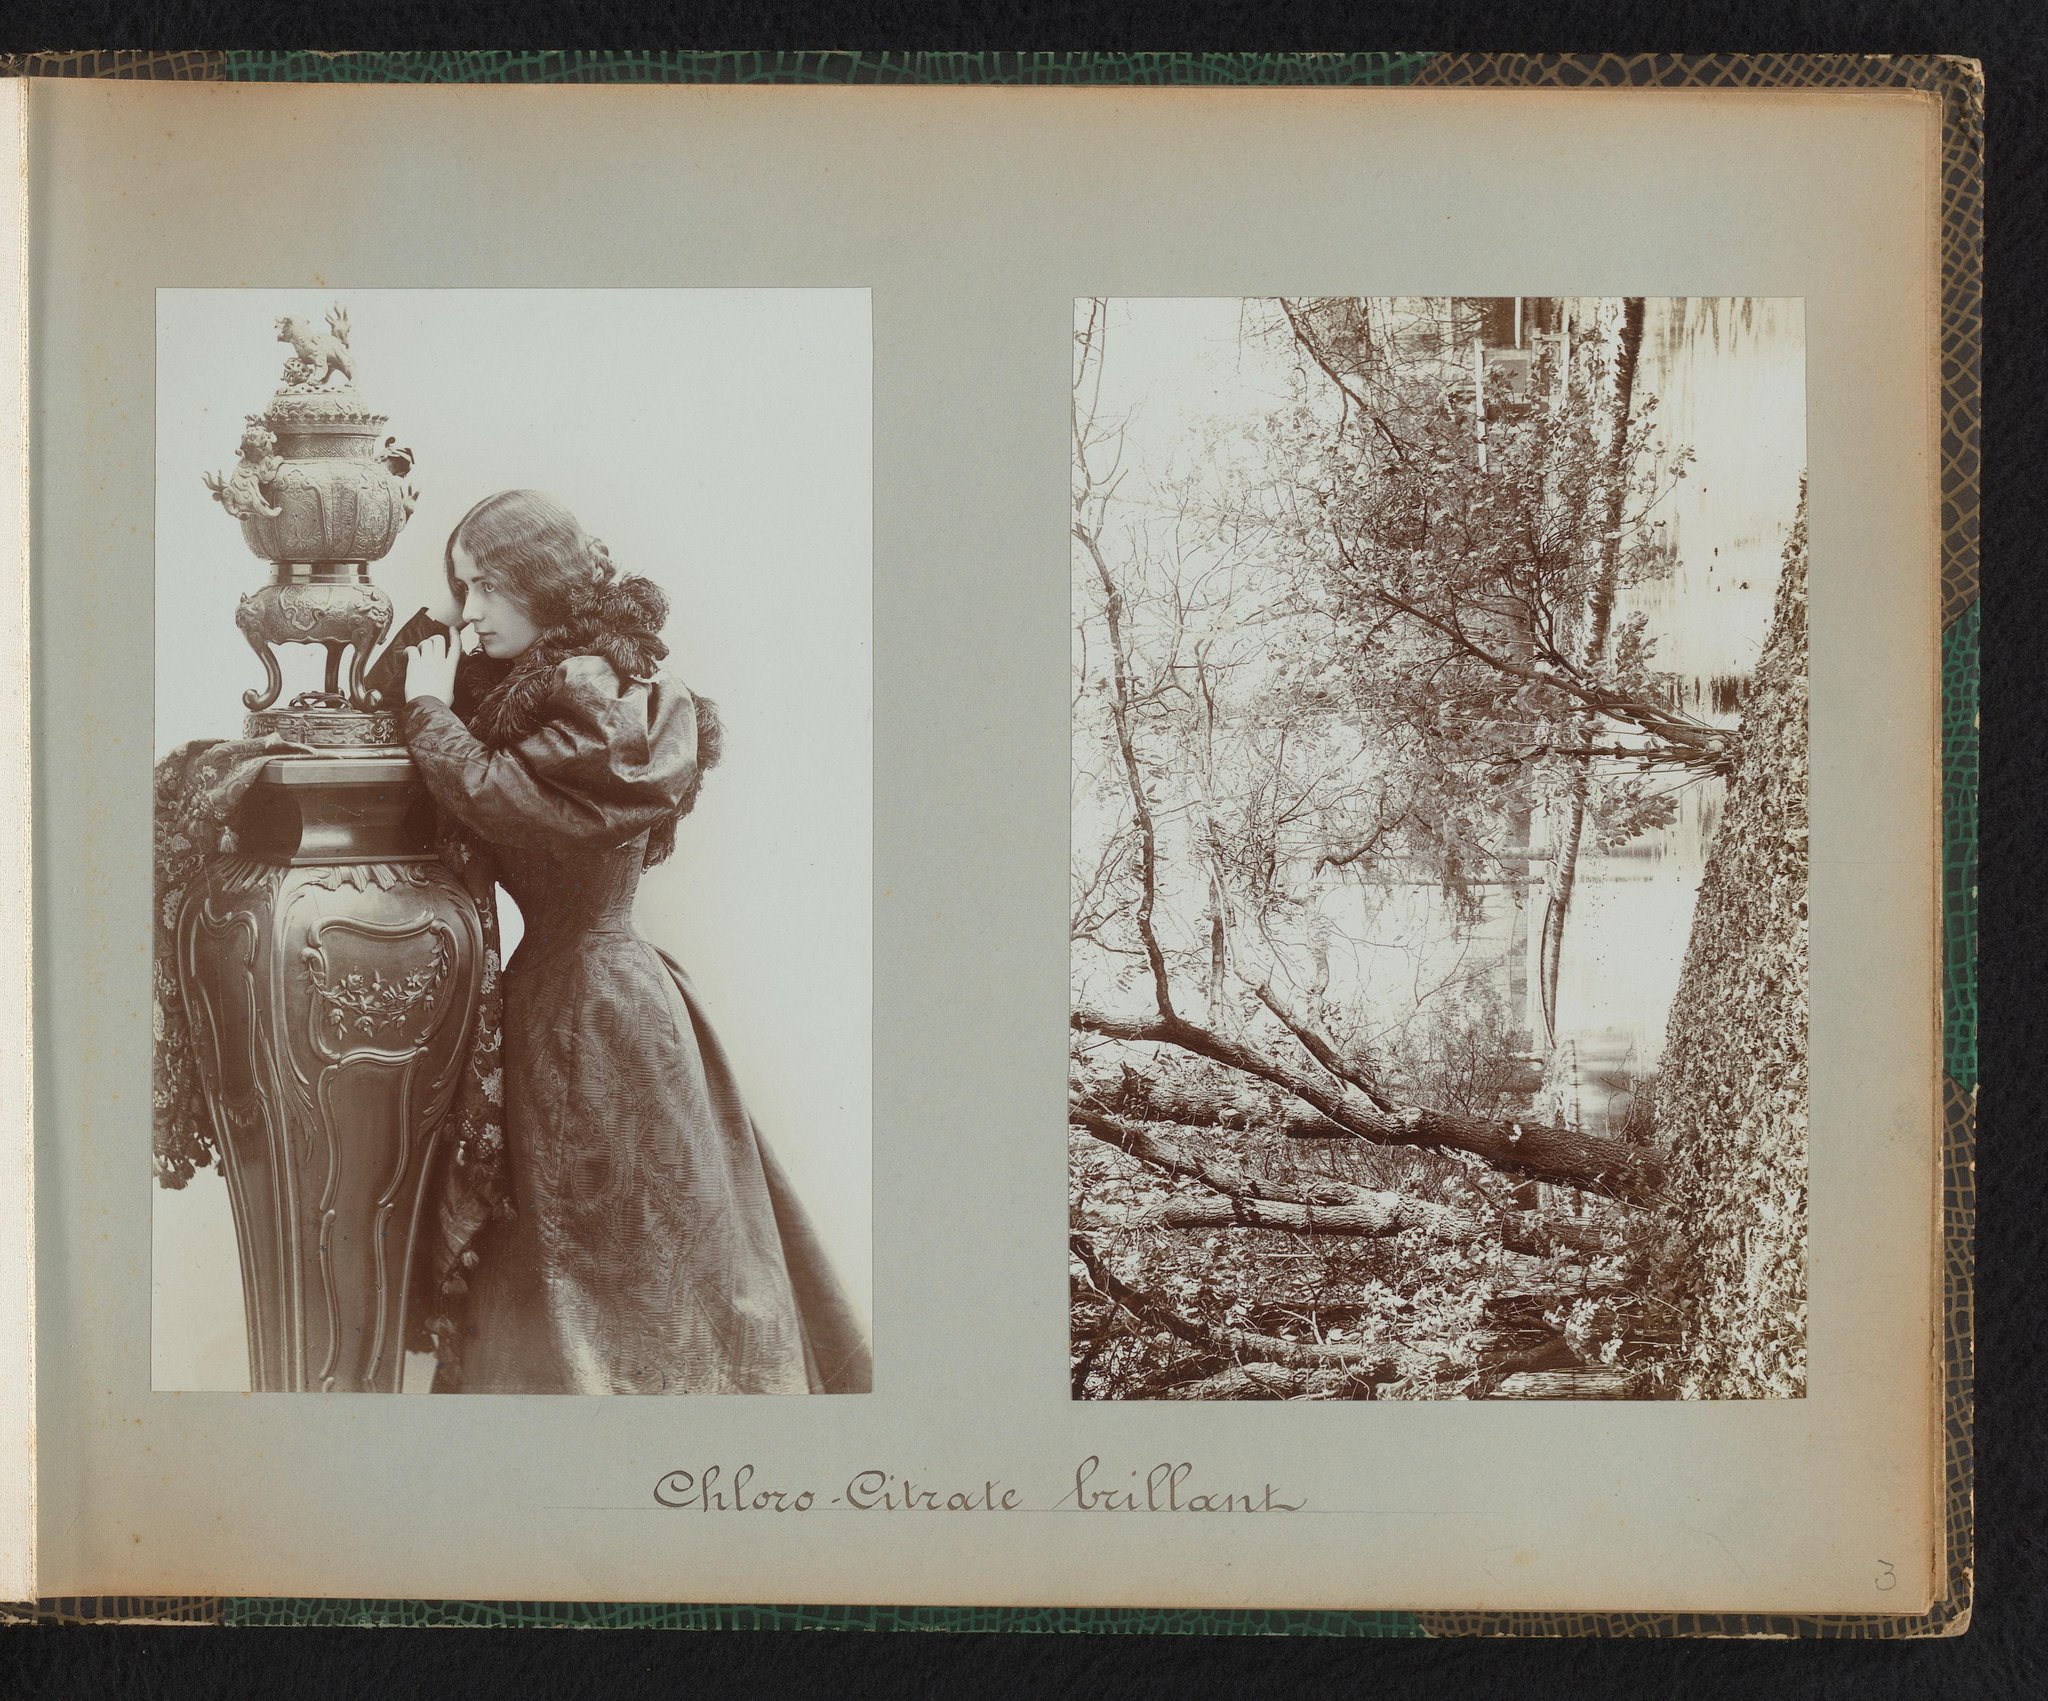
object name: page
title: Portret van een vrouw leunend tegen een ornament en een gezicht op een rivier met brug en bomen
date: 1890-1910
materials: paper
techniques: gelatin silver print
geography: paris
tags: ornaments ~ art, river, historical persons not known by name - bb - woman, landscape with bridge, viaduct or aqueduct, leaning figure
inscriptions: inscription: ‘Chloro-Citrate brilliant’